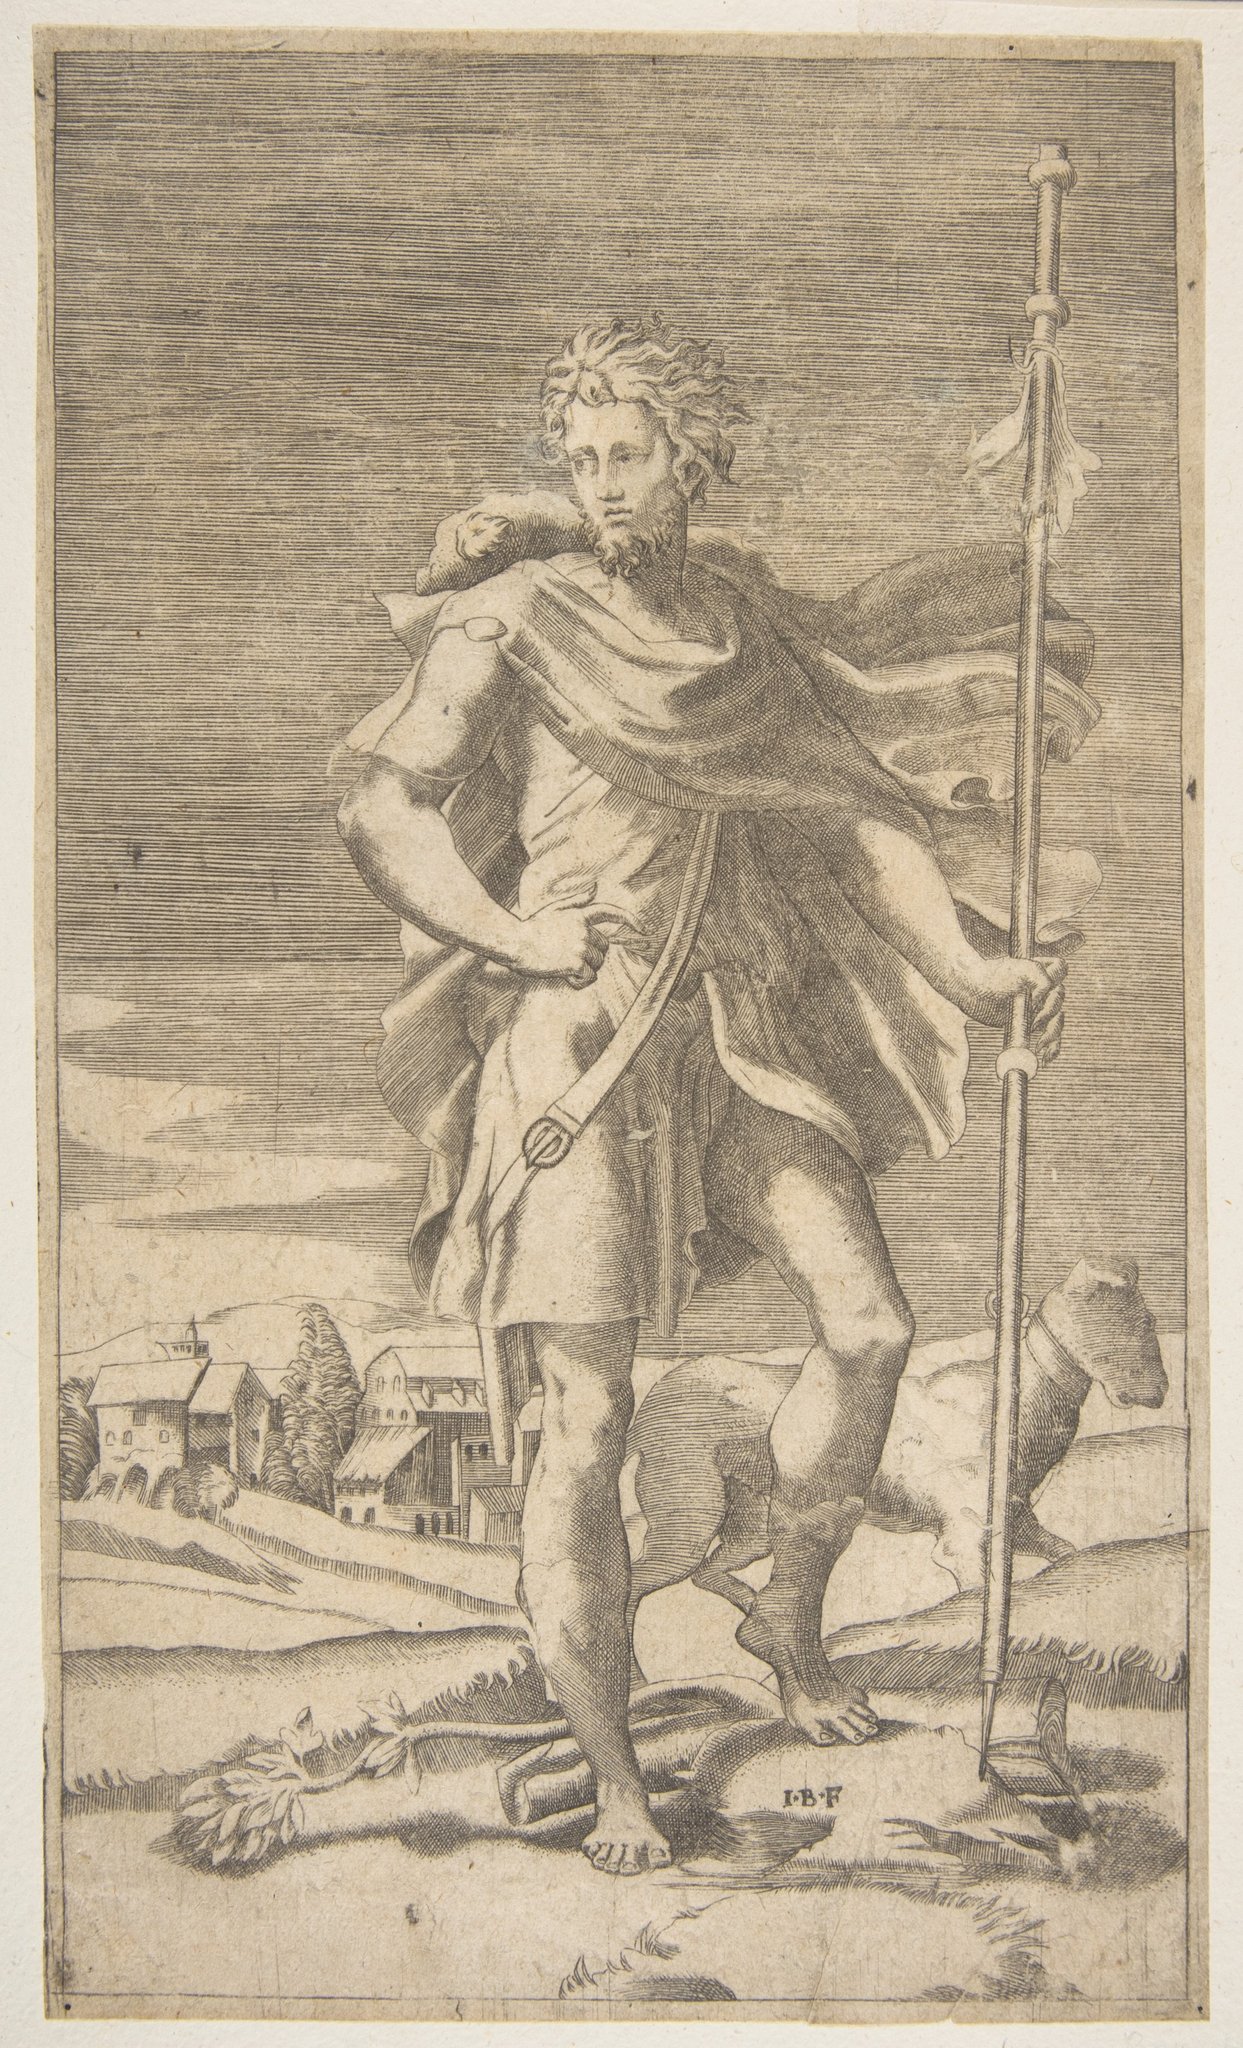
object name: print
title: Saint Roch standing holding a staff in his left hand, a dog by his side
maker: giulio bonasone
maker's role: artist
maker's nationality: italian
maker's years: 1510-1576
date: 1531-1576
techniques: engraving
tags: dogs,saints